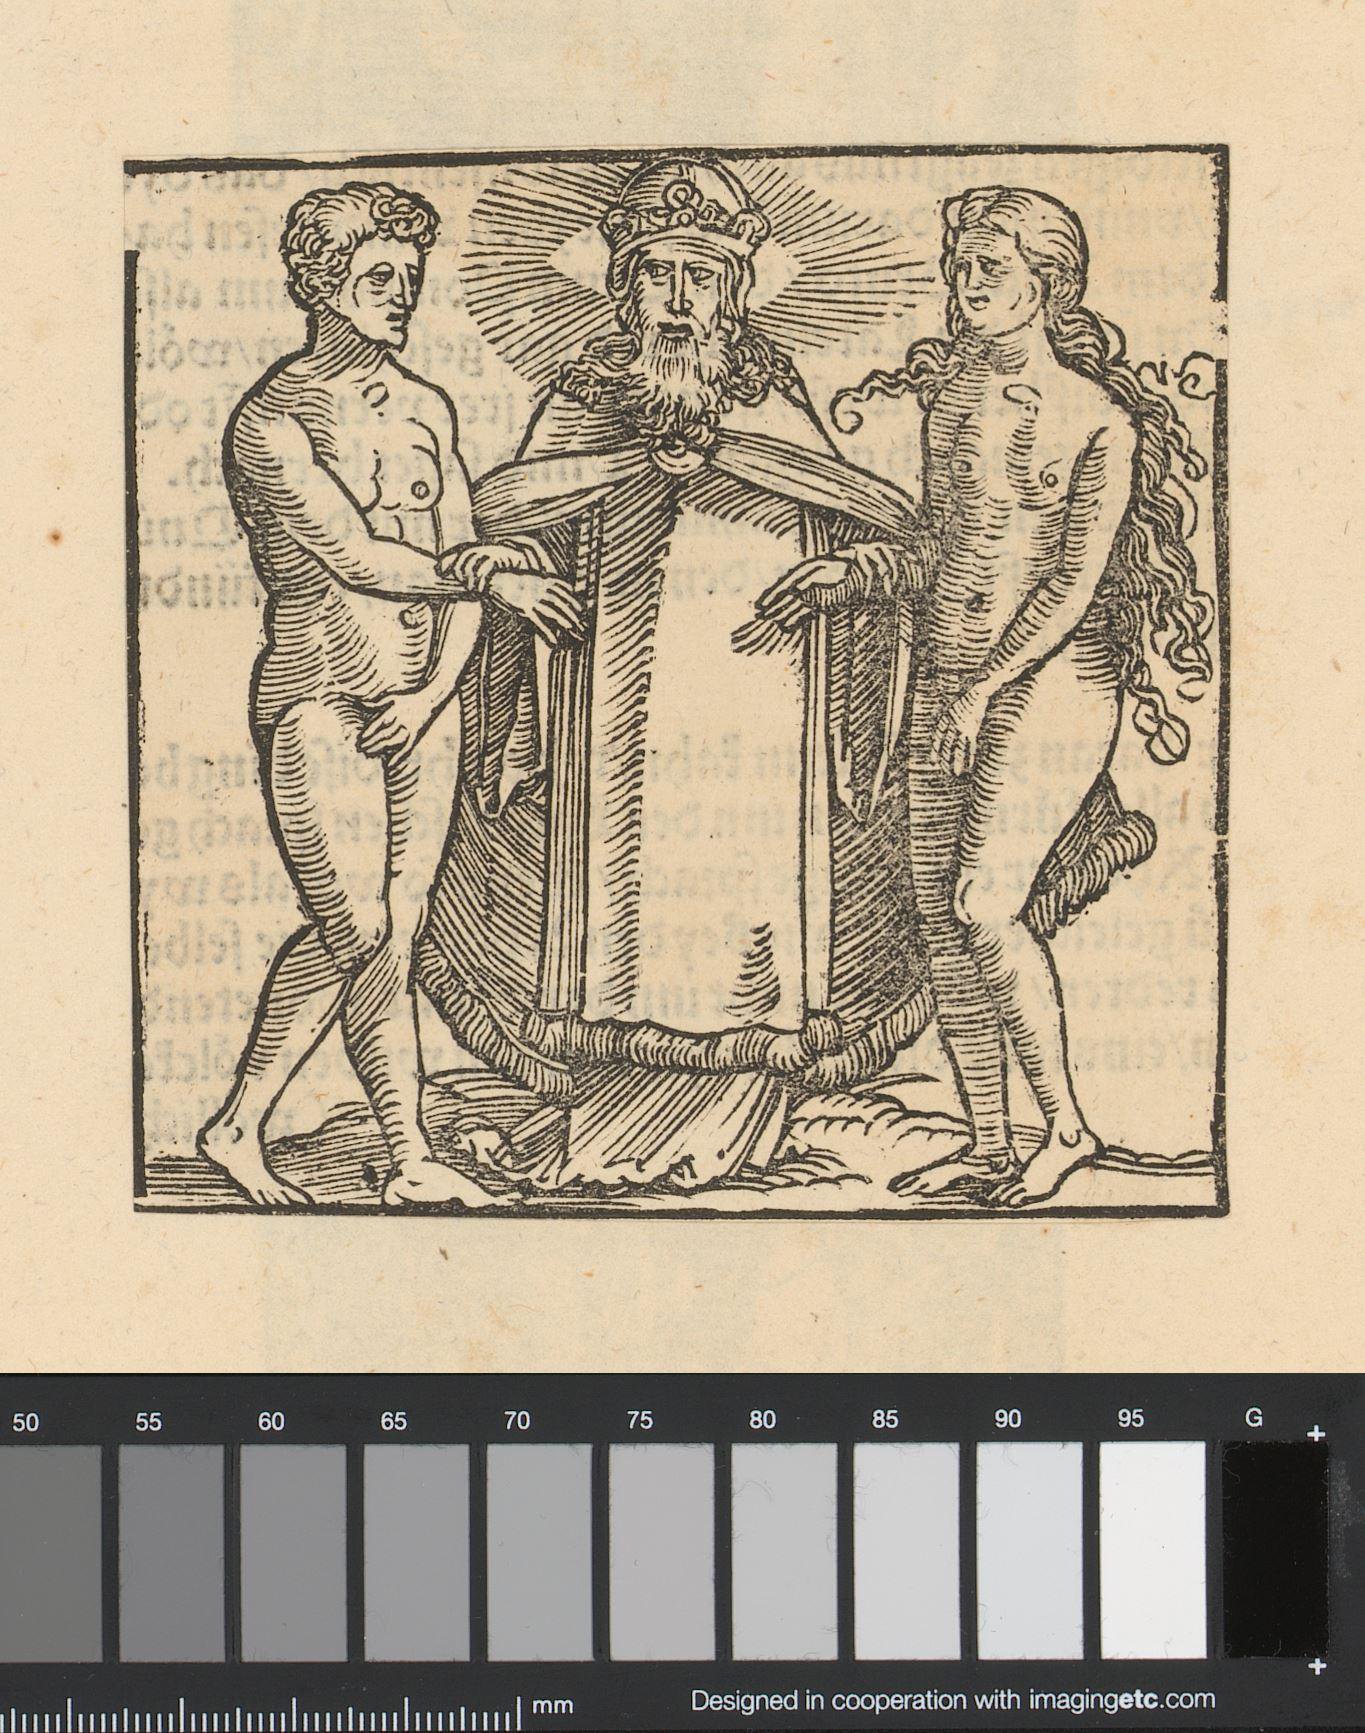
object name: album leaf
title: Huwelijk van Adam en Eva voltrokken door God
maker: Anonymous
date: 1510-1525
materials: paper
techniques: letterpress printing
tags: walks in the garden of eden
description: Deze prent is gebruikt in: Schwarzenberg, Johann. Die Beschwörung der alten teufelischen Schlangen mit dem göttlichen Wort. Neurenberg: Hans Herrgott, 1525.